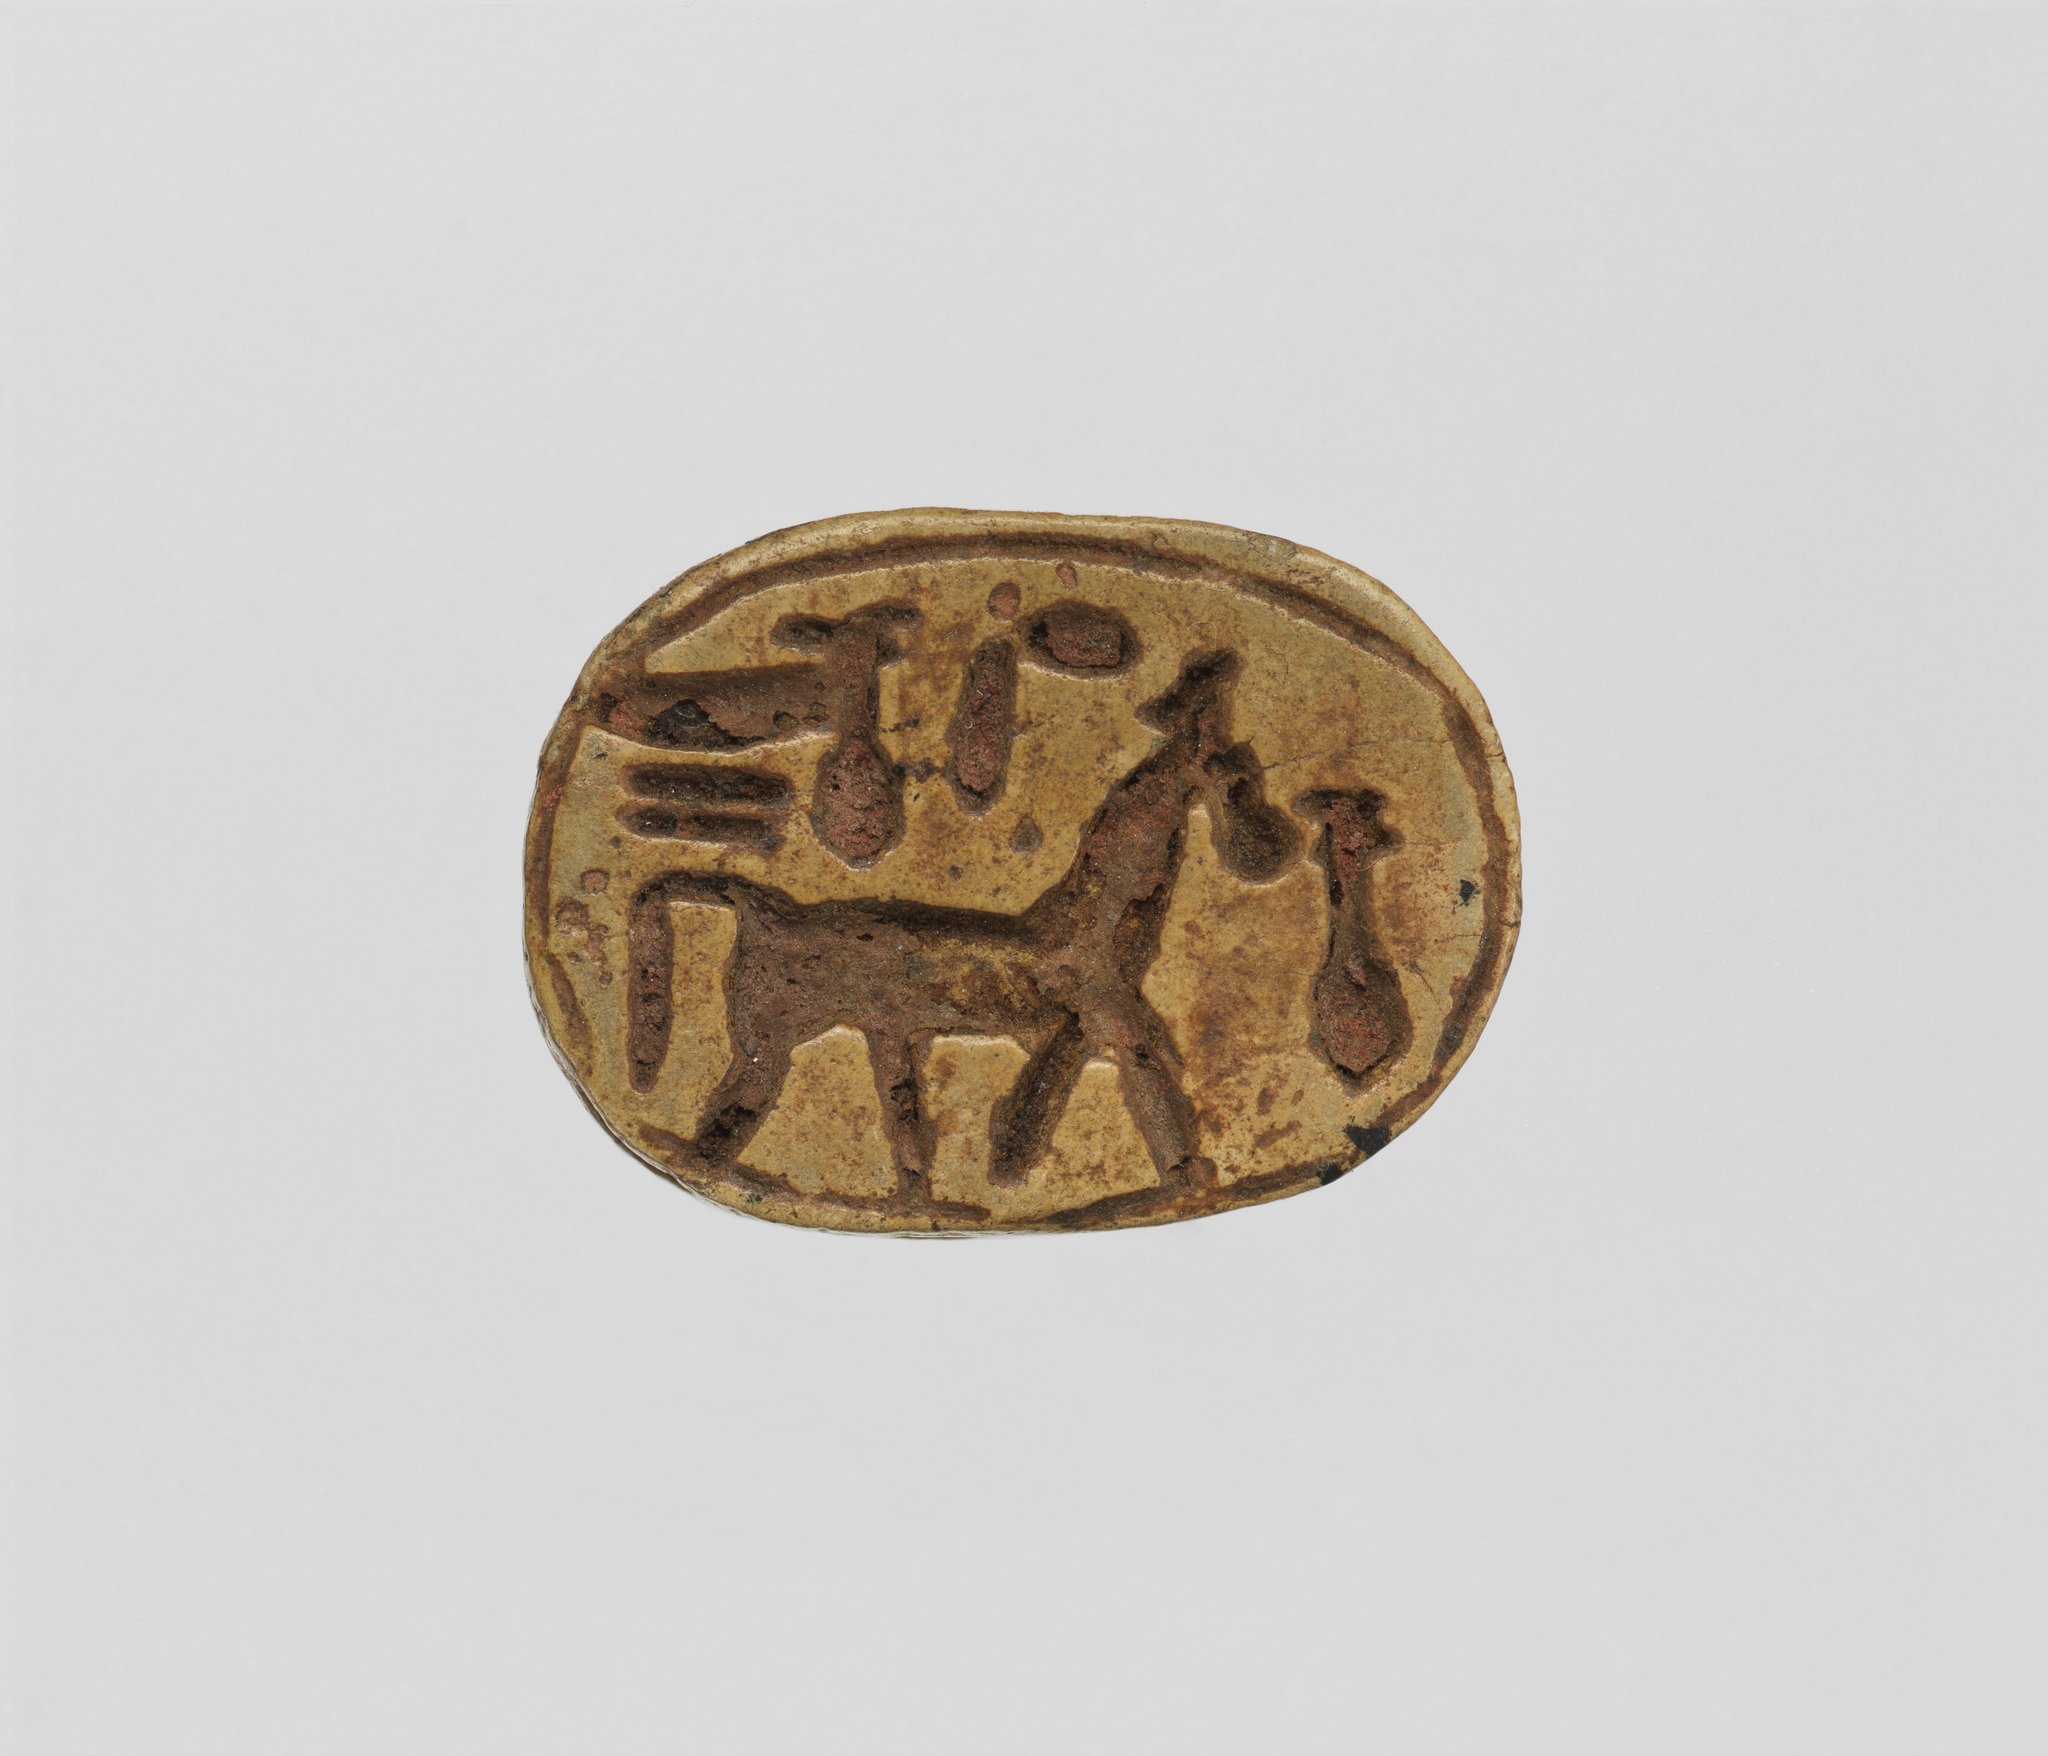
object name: scaraboid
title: Scarab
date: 1295-1070 BCE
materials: faience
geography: egypt